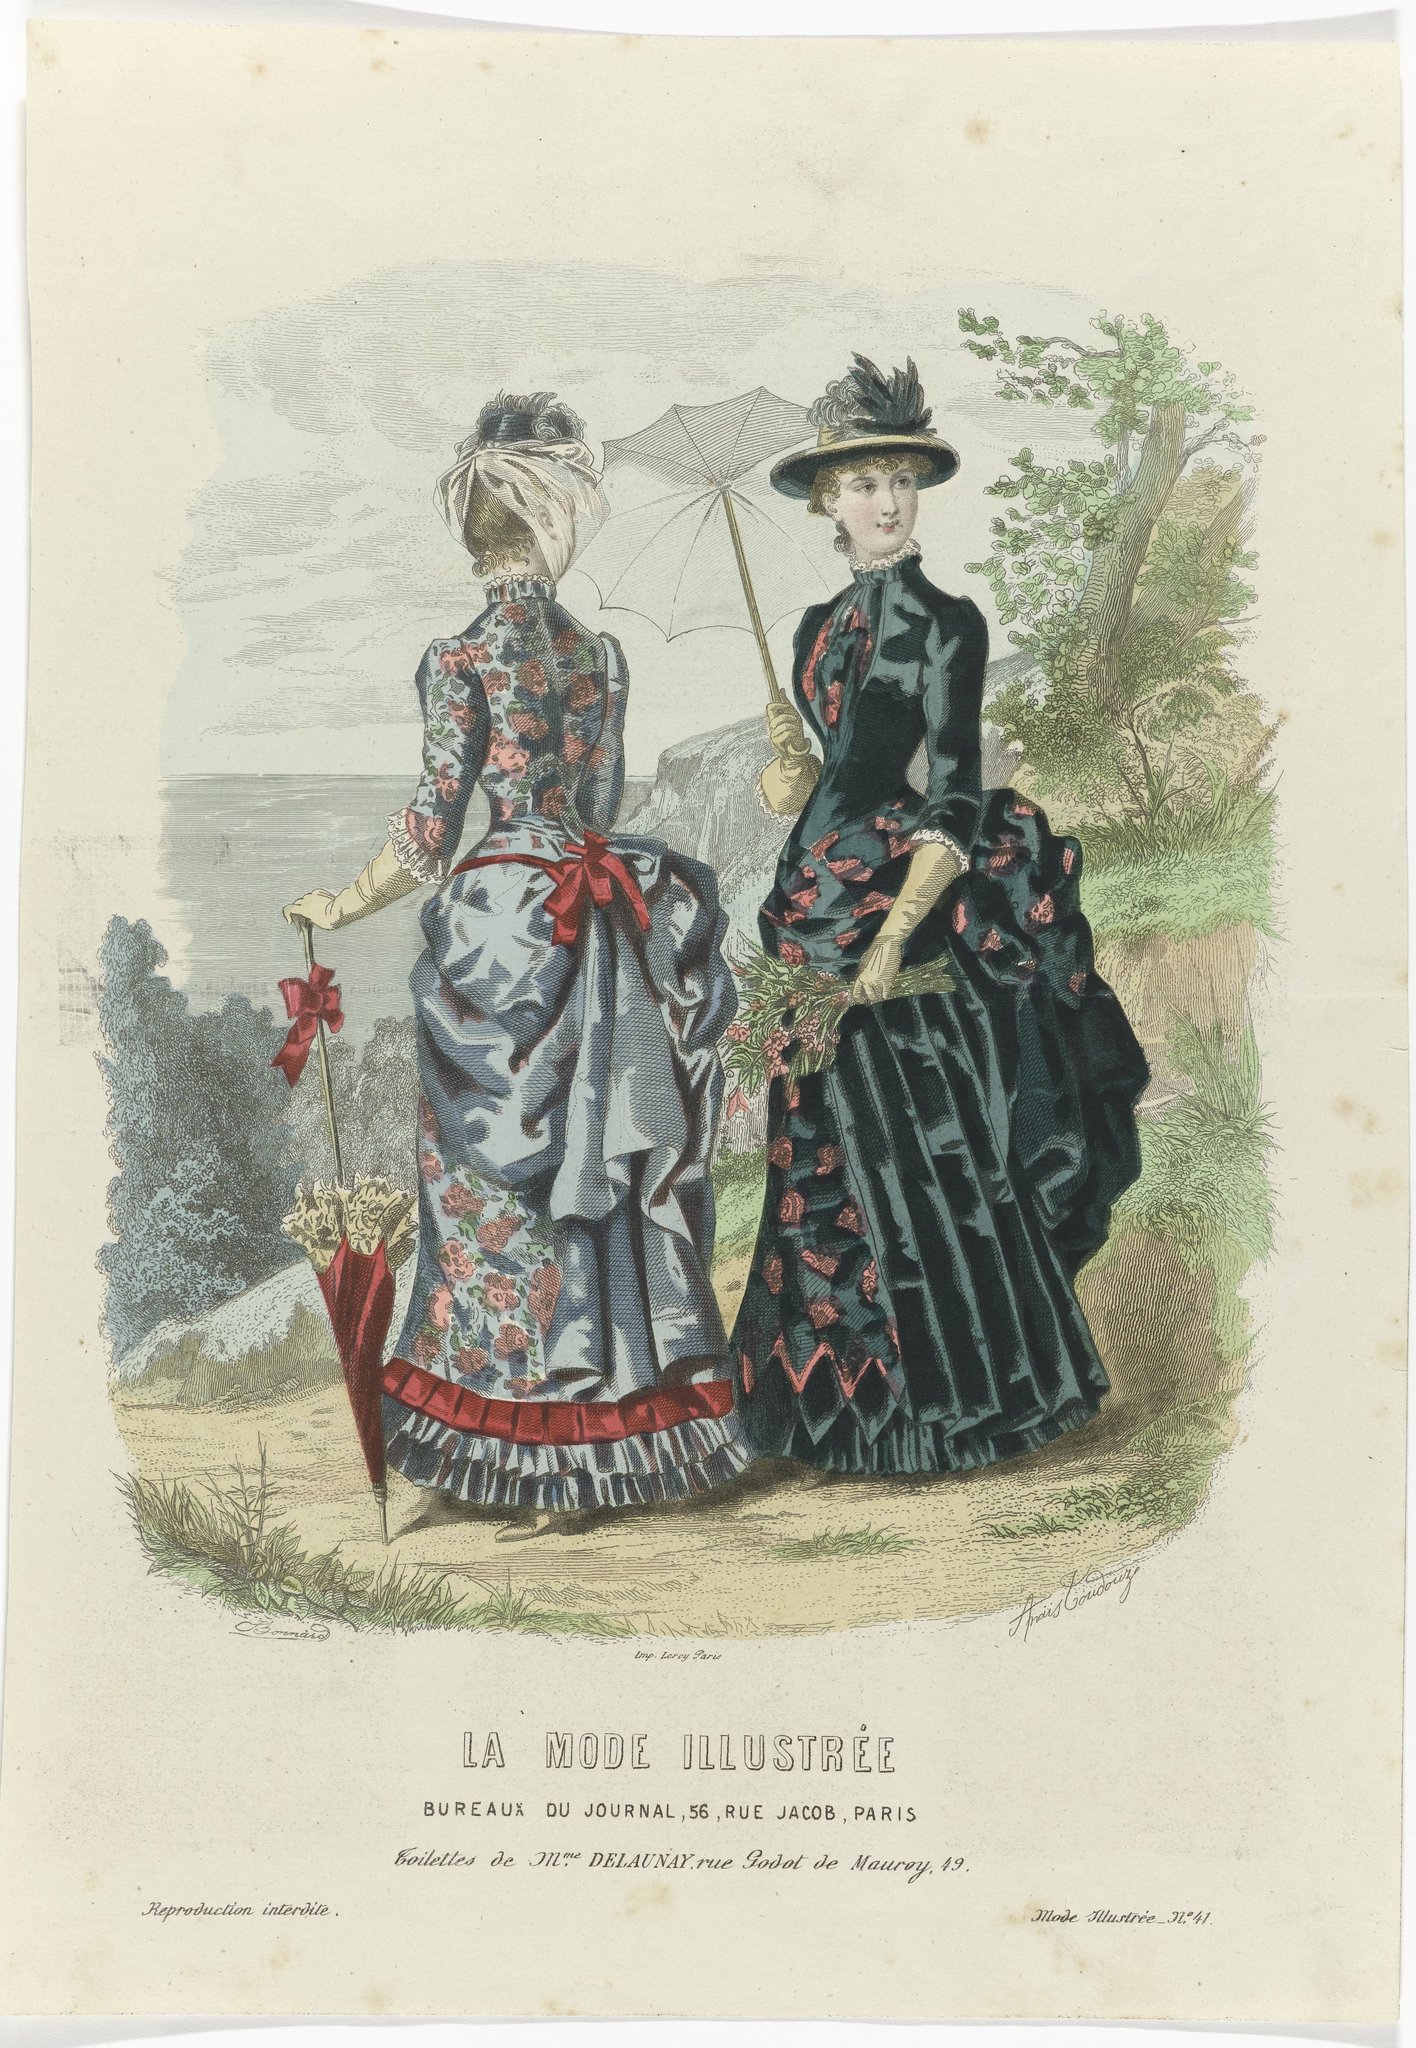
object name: fashion print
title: La Mode Illustrée, 1883, No. 41 : Toilettes de Mme Delaunay (...)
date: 1883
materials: paper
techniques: engraving, hand coloring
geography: paris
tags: cut flowers; nosegay, bunch of flowers, walking-stick, staff, cane (+ women's clothes), veil (+ women's clothes), landscapes in the temperate zone, fashion plates, head-gear: hat (+ women's clothes), gloves, mittens, etc. (+ women's clothes), dress, gown (+ women's clothes), parasol, sunshade (+ women's clothes)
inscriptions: title: ‘La Mode Illustrée’, caption: ‘Toilettes de M.me Delaunay, rue Godot de Mauroy, 49.’, address: ‘Bureaux du journal, 56, rue Jacob. Paris’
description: Twee vrouwen op een heuvel, in japonnen van Delaunay met wandelstok, die ook als parasol kan worden gebruikt. Prent uit het modetijdschrift La Mode Illustrée (1860-1937).